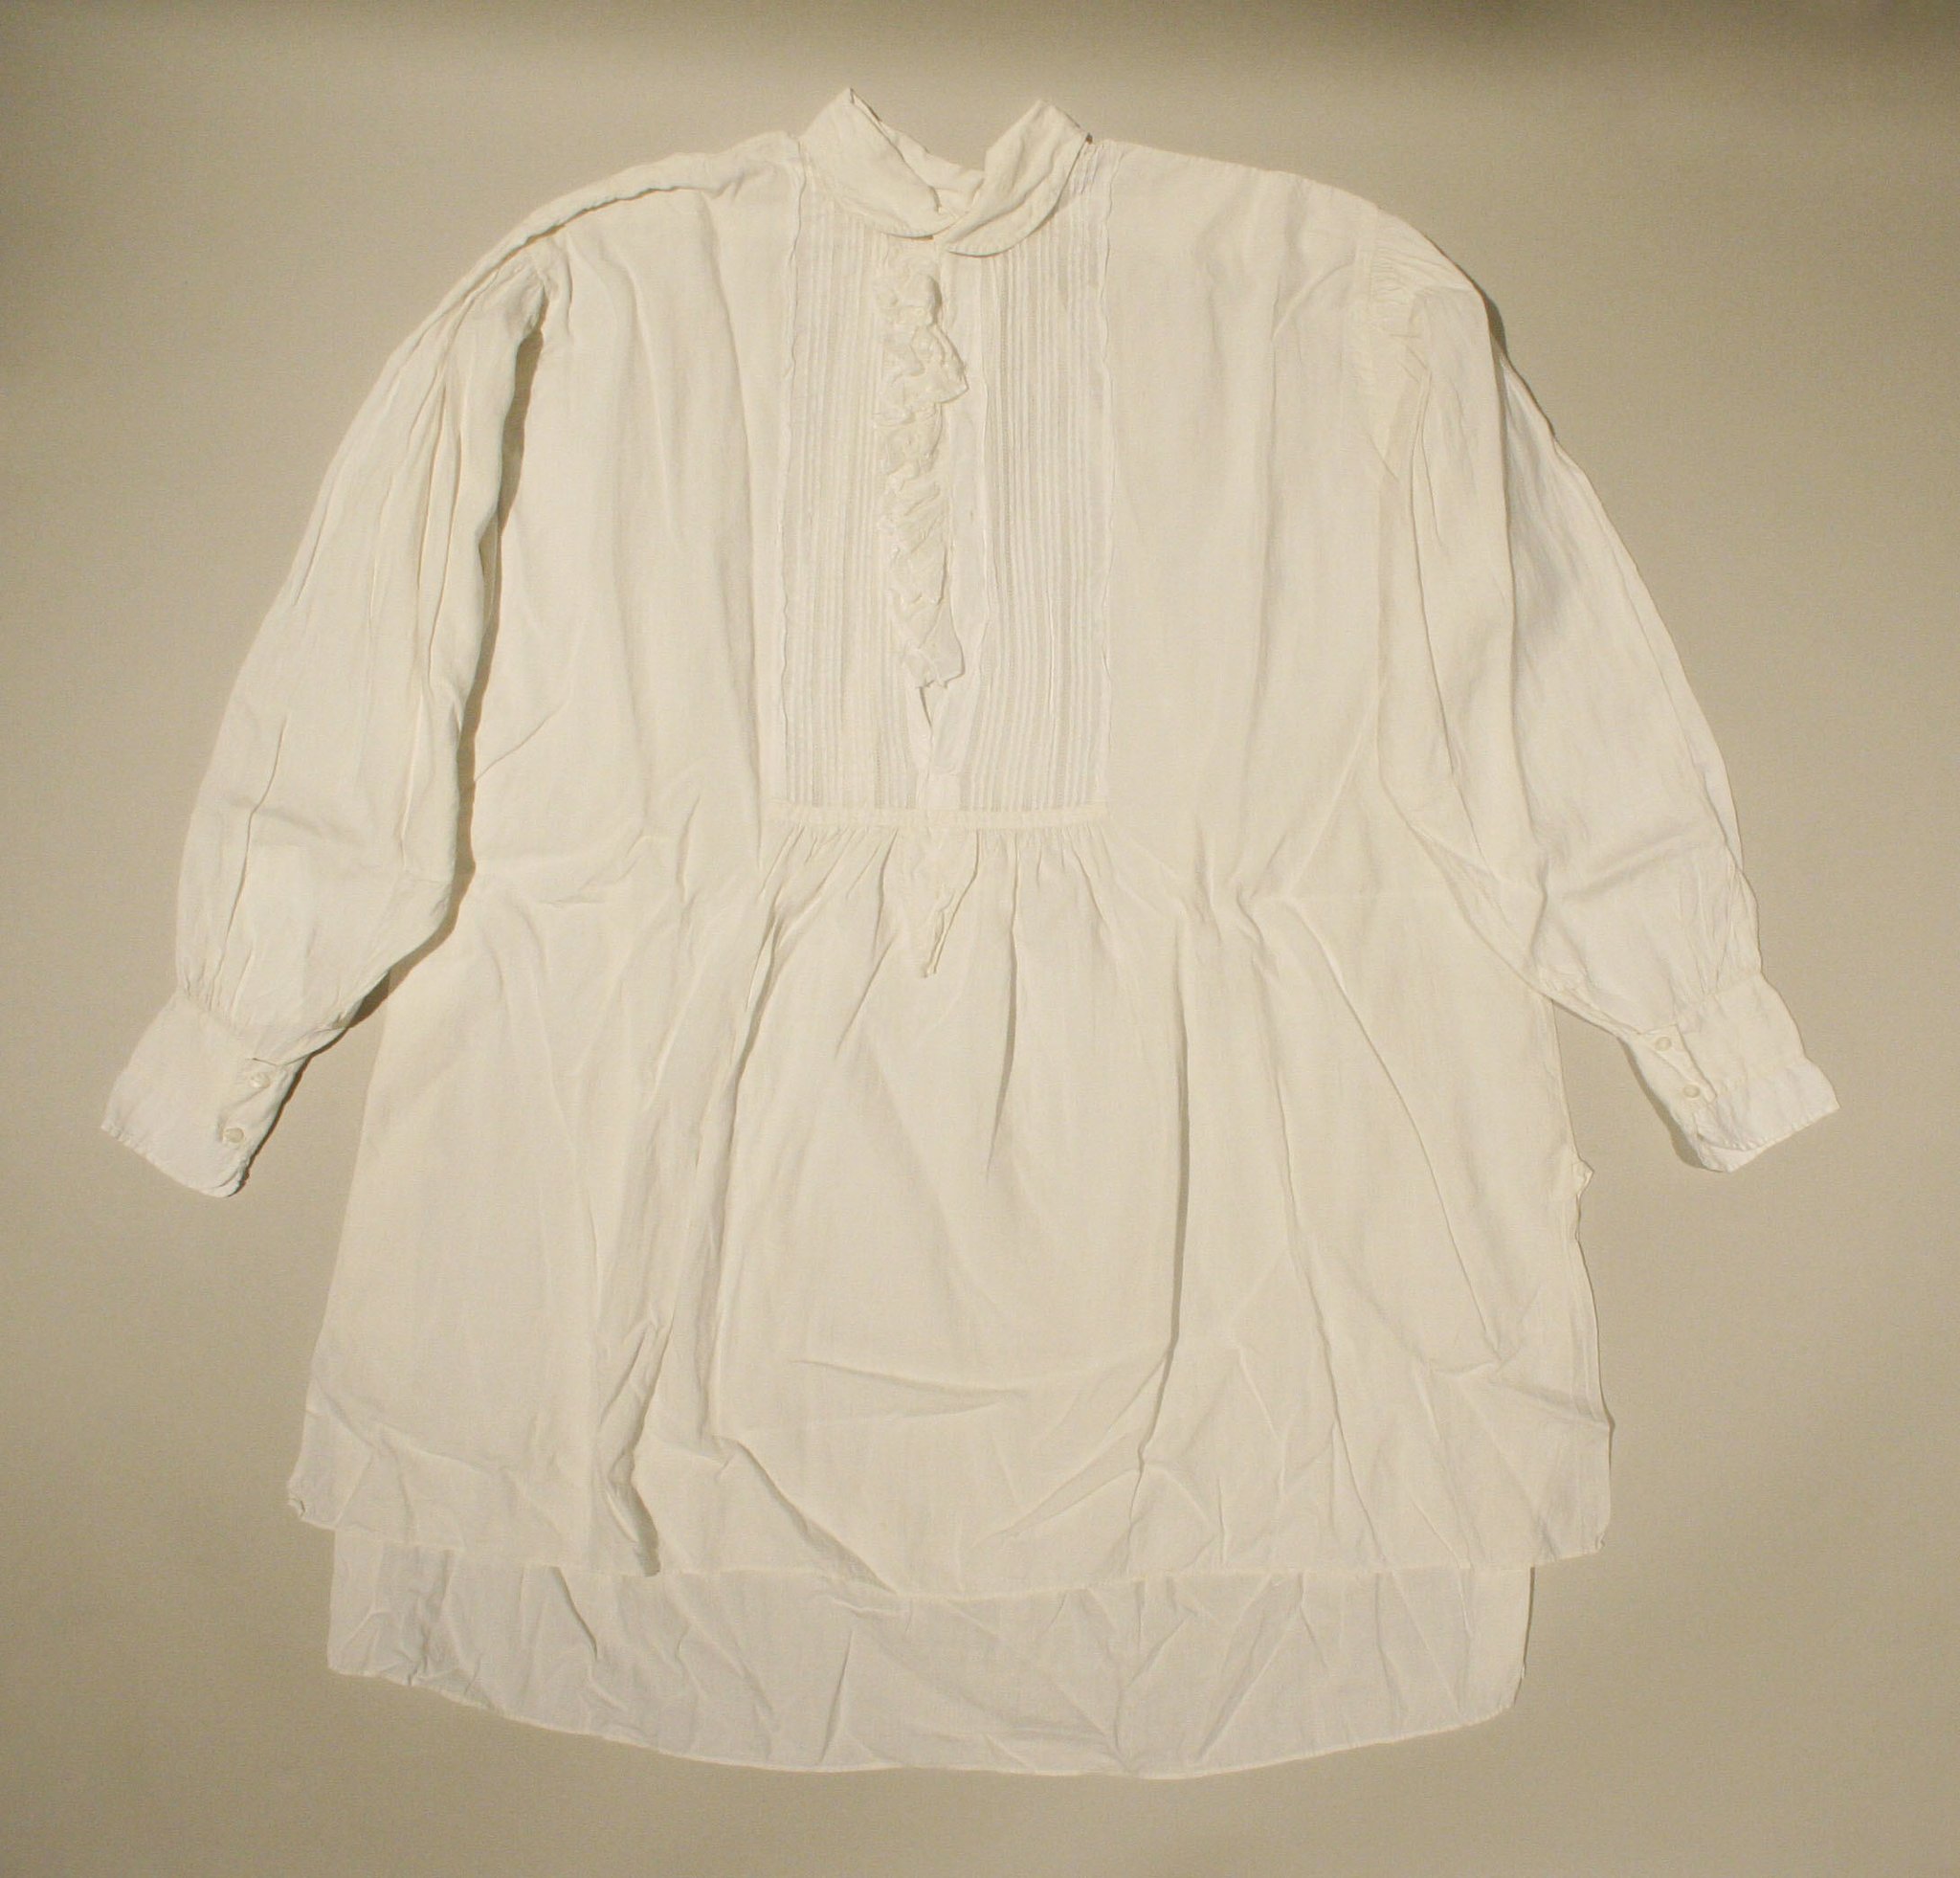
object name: shirt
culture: french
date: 1865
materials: cotton